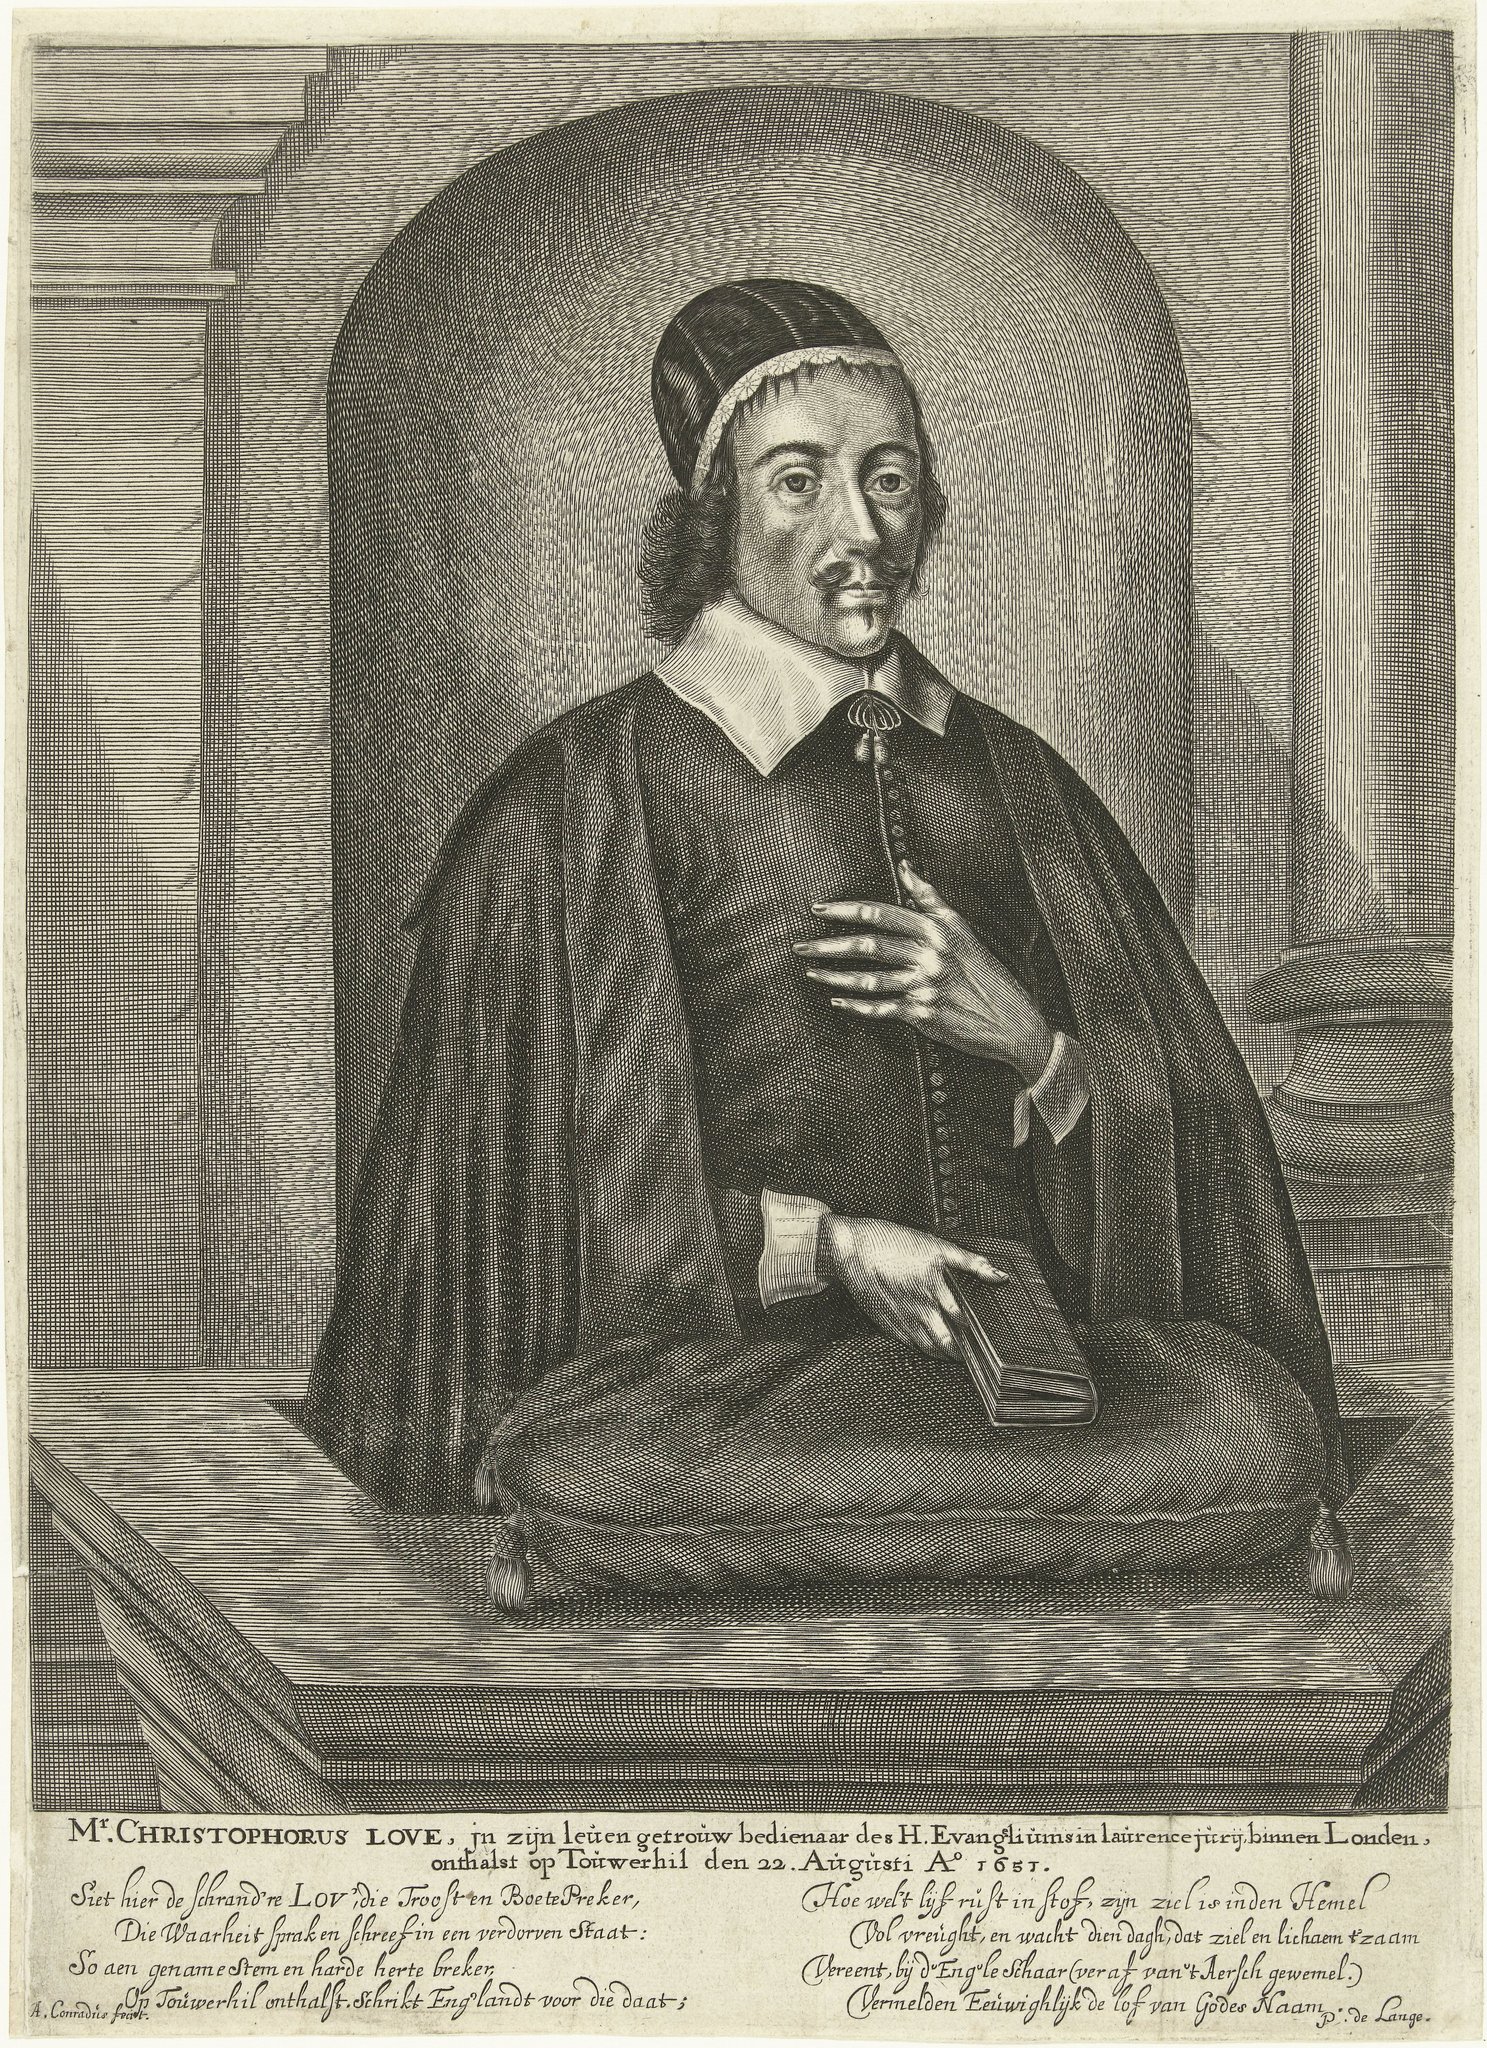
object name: print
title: Portret van Christopher Love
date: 1651-1652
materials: paper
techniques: engraving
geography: amsterdam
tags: london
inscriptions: collector's mark: Lugt 2228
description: Portret van de Waalse predikant Christopher Love, in het preekgestoelte met een boek in zijn handen. Love werd in 1651 in Londen onthoofd. Onder het portret een vers van P. de Lange.